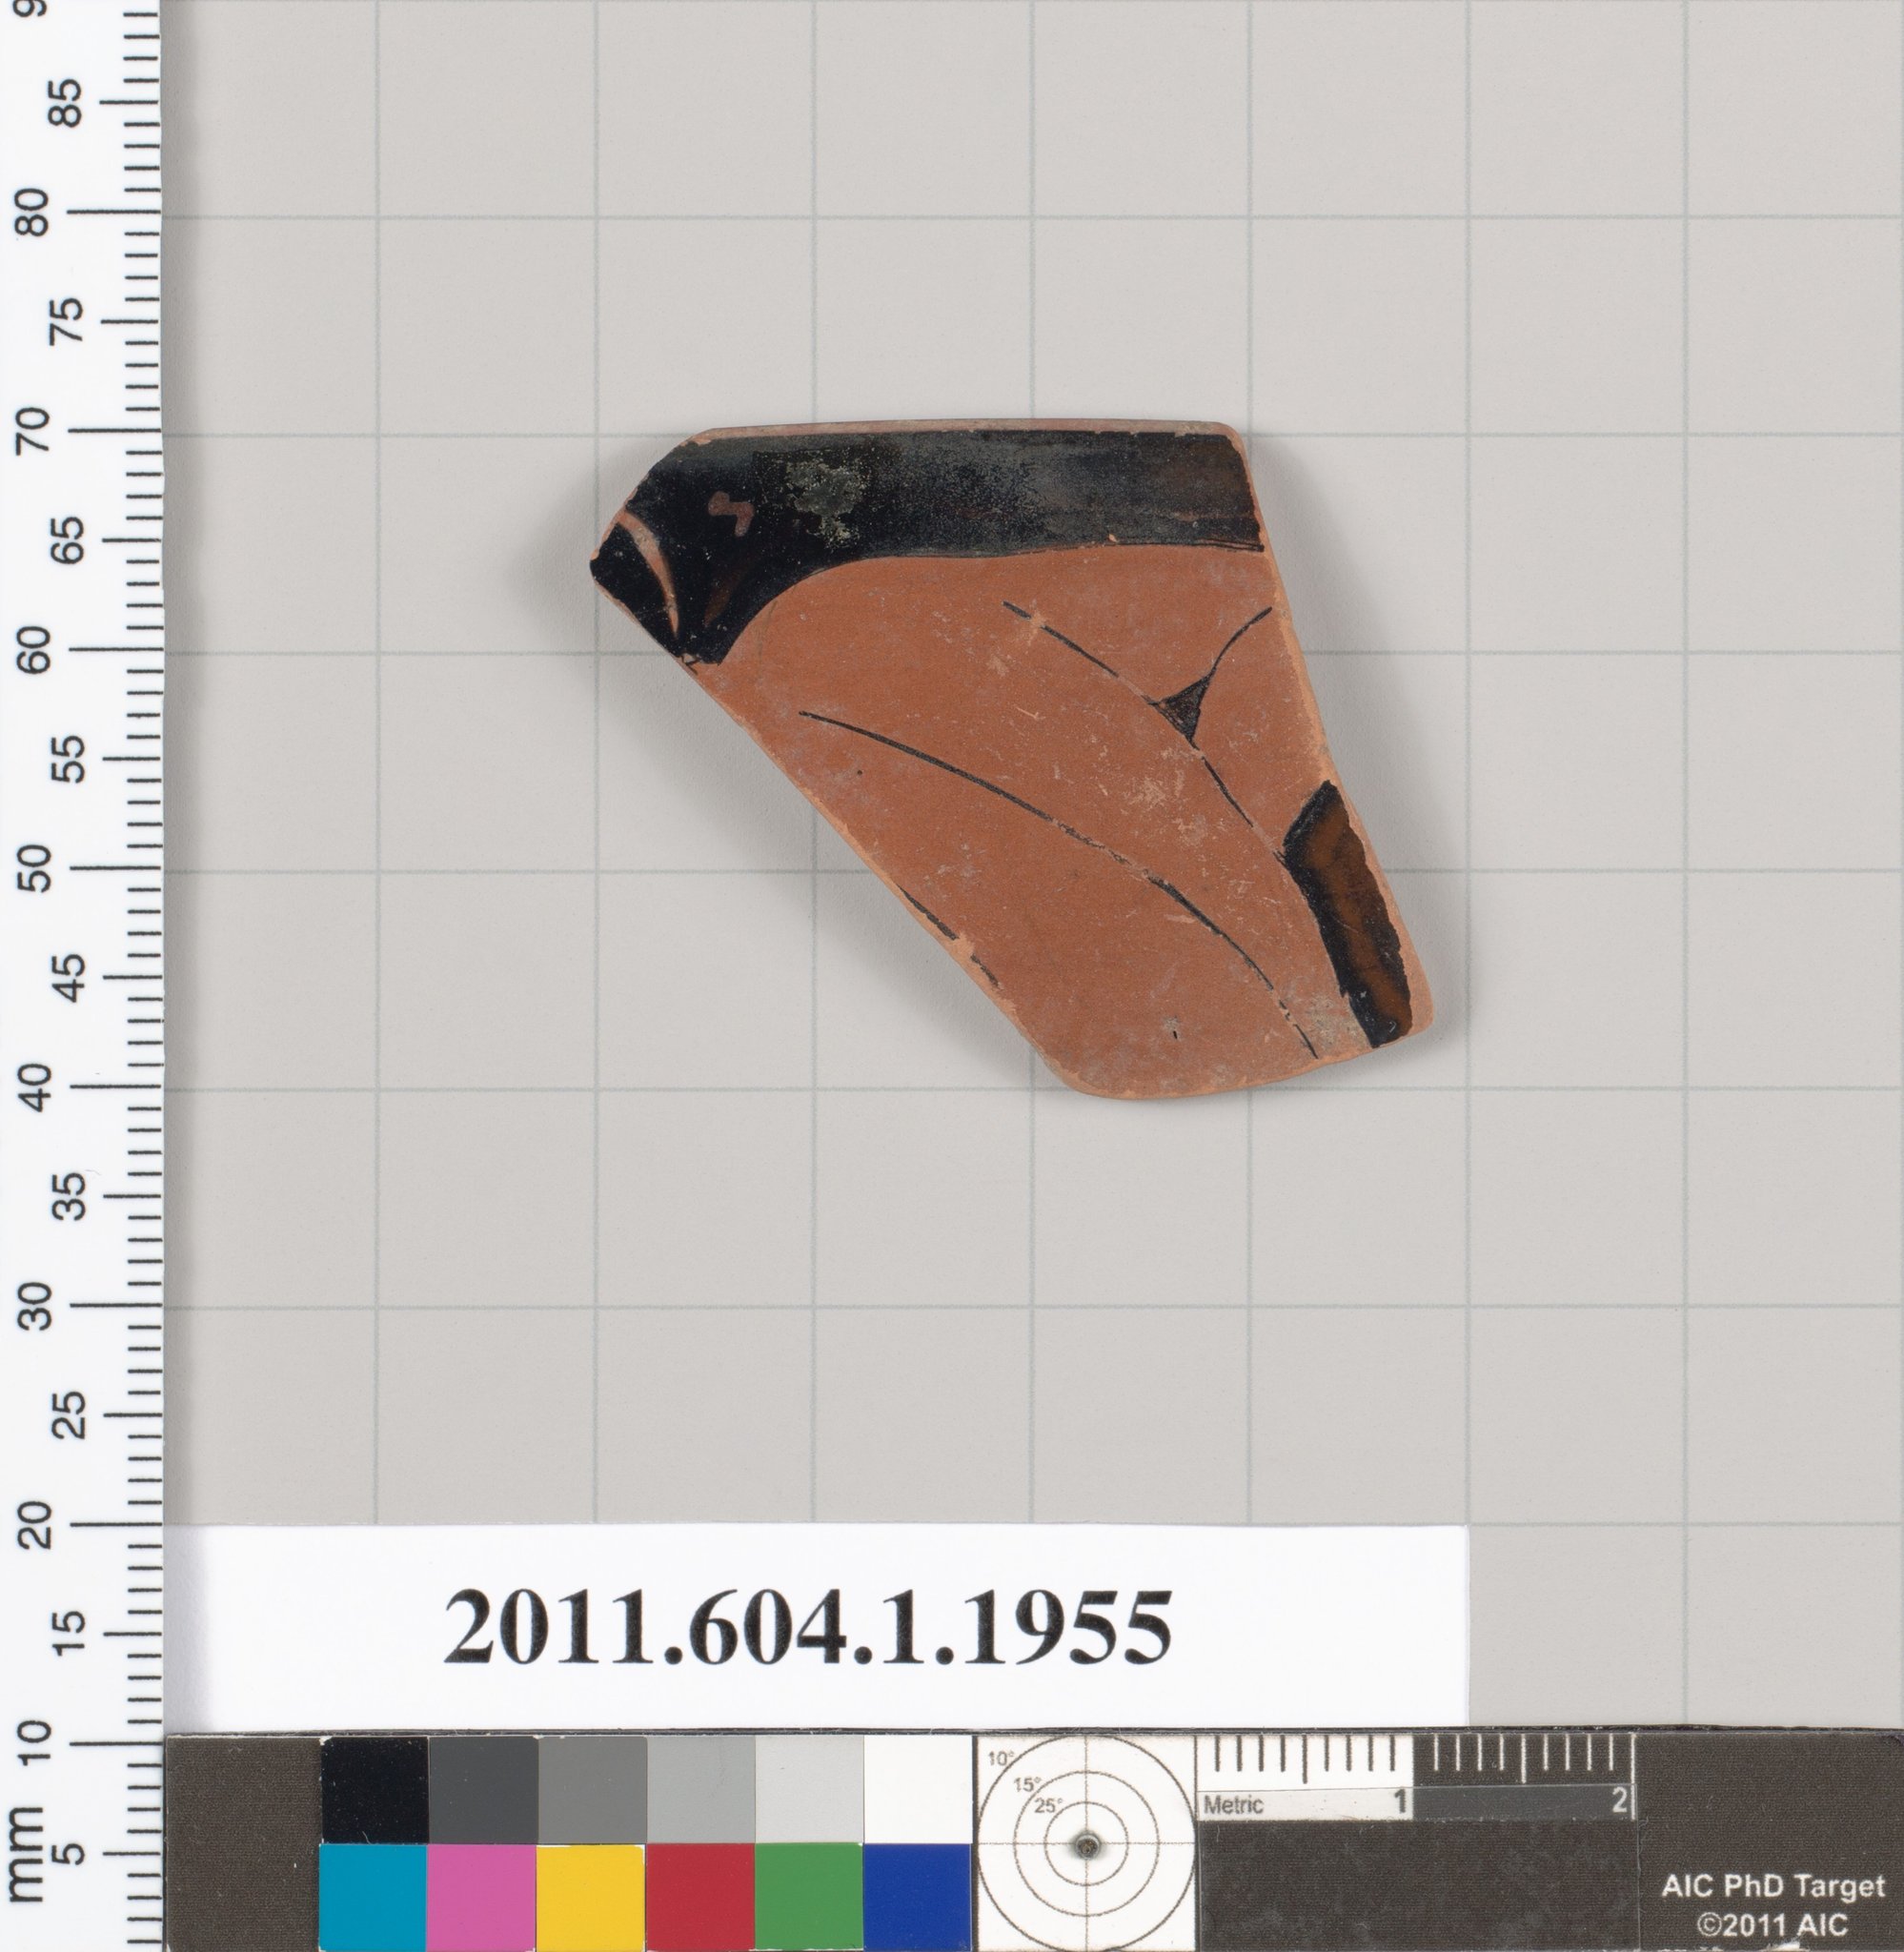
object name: kylix fragment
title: Terracotta rim fragment of a kylix (drinking cup)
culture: greek, attic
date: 500-451 BCE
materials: terracotta